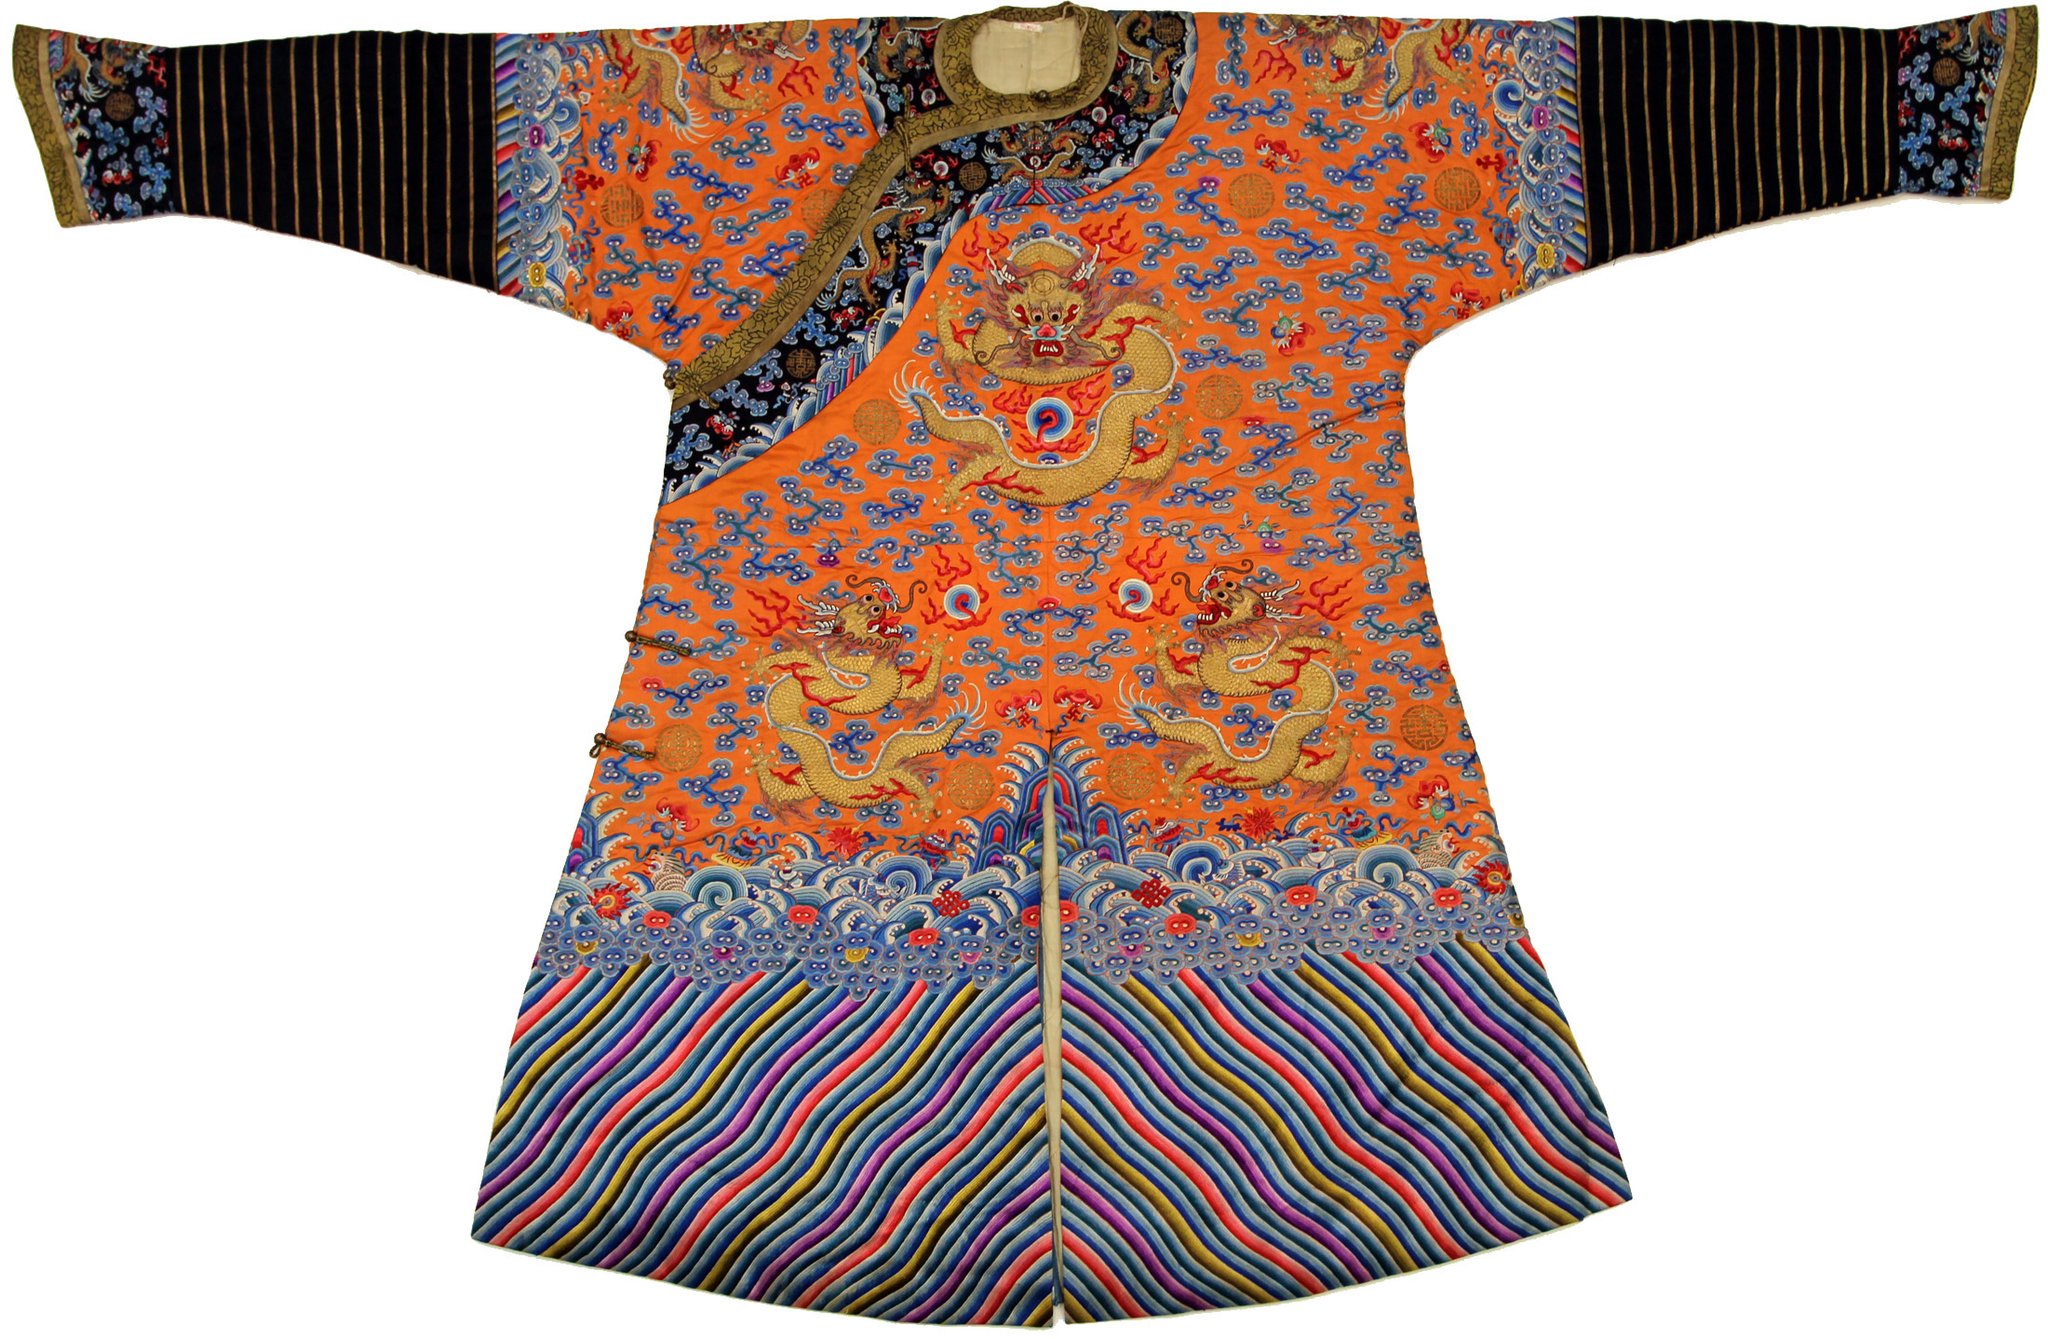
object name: robe, imperial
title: Imperial Robe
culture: chinese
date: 1834-1866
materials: silk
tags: dragons